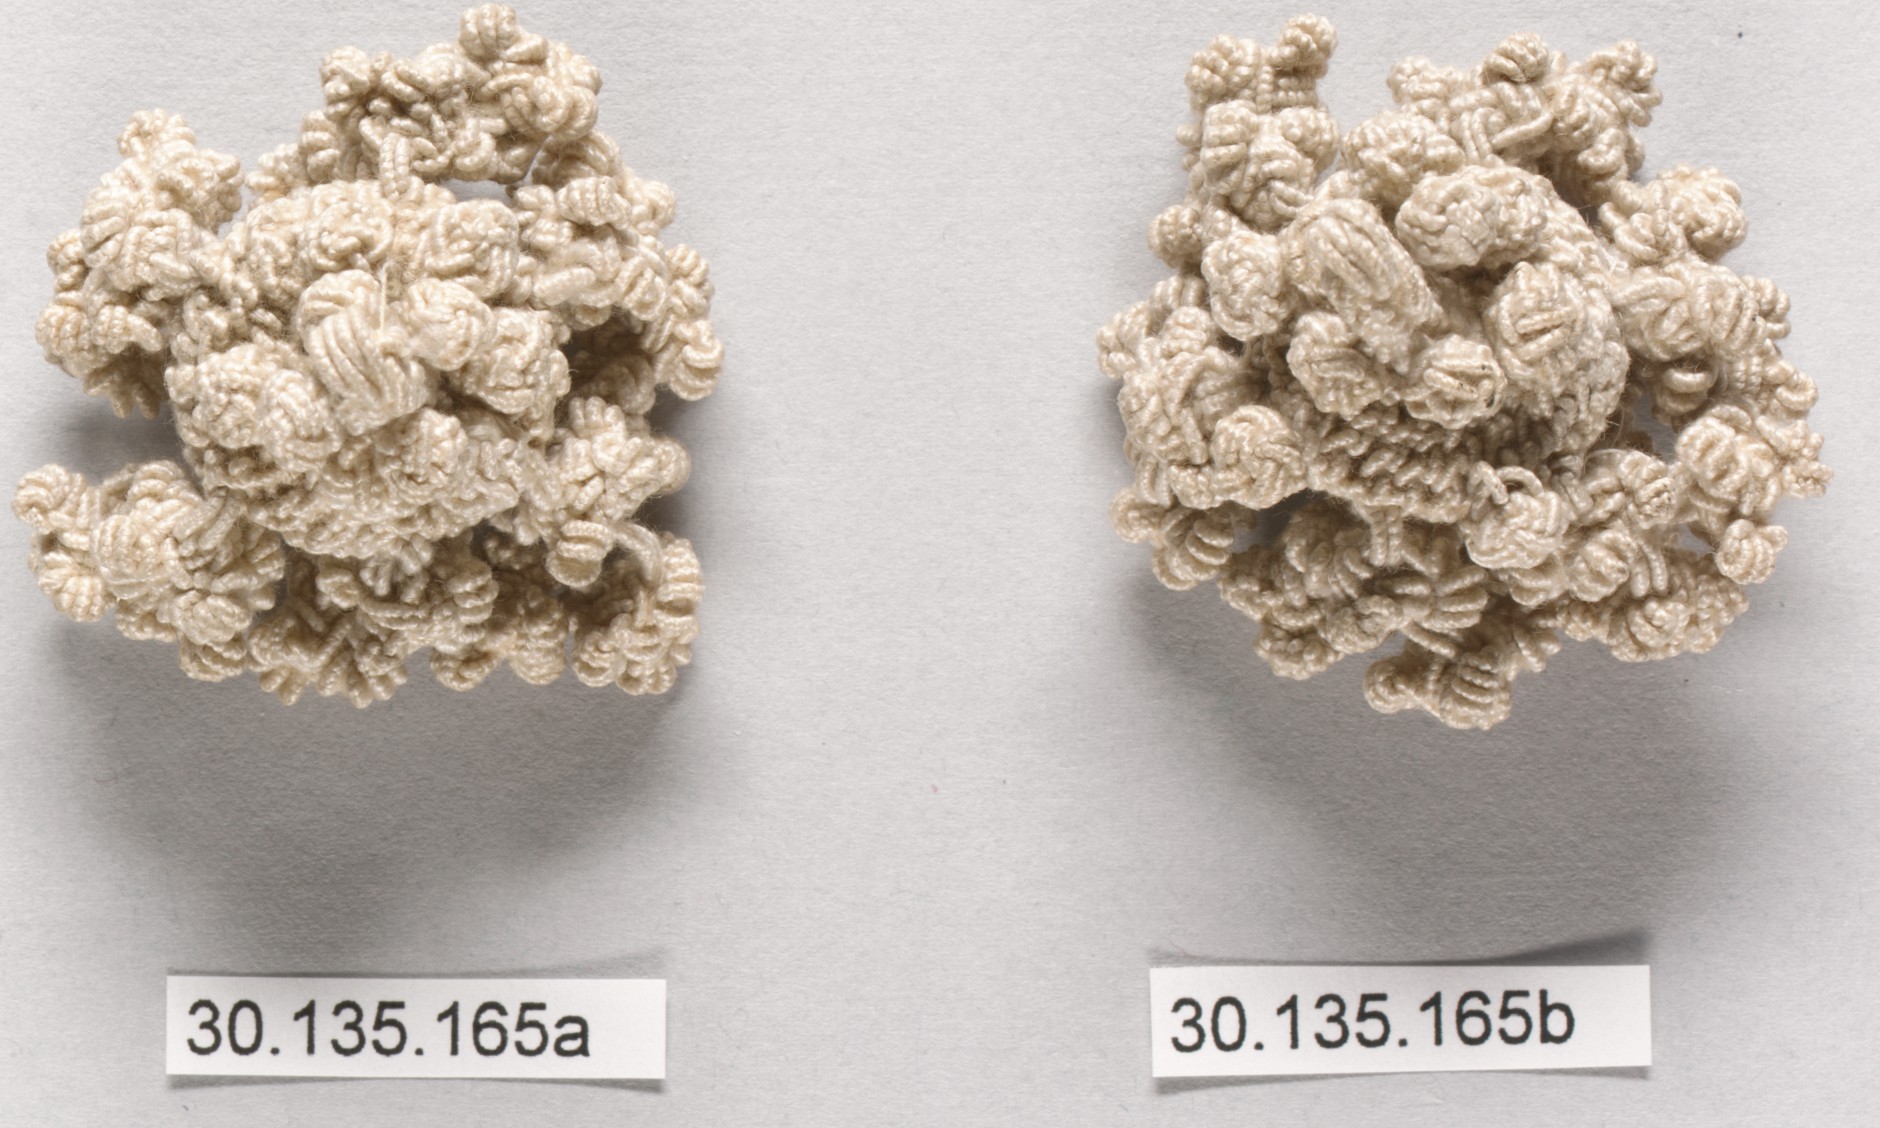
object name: tassel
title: Pair of tassels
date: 1601-1700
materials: linen